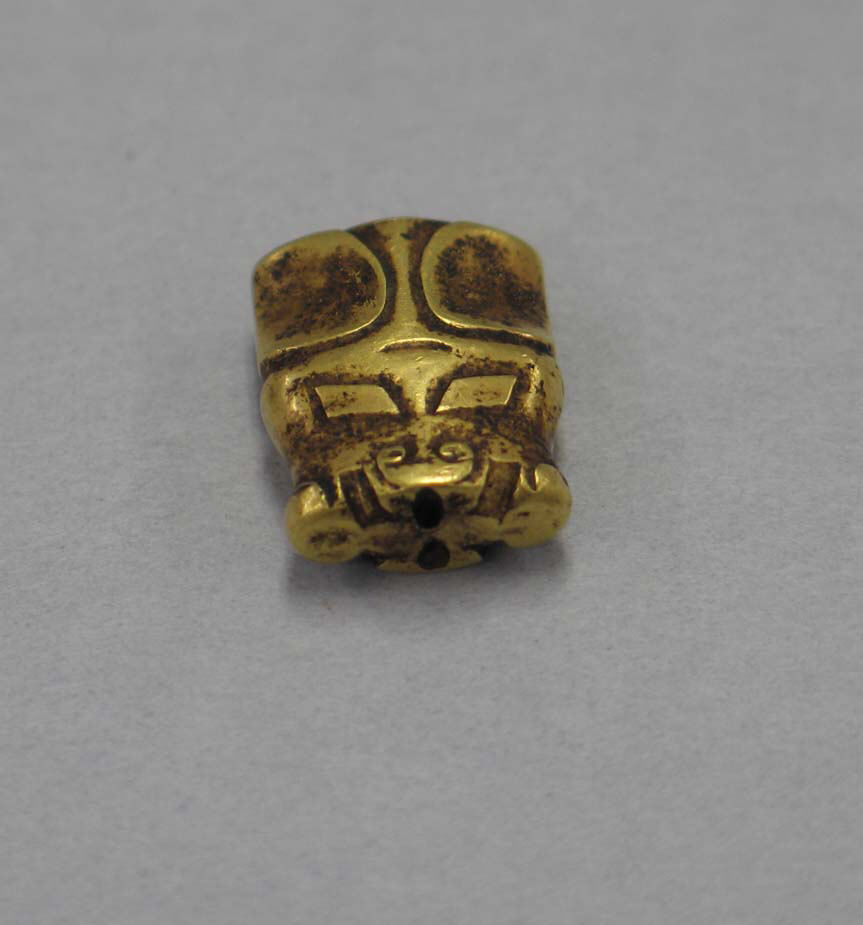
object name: ornament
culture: chinese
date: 1046-256 BCE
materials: gold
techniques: casting